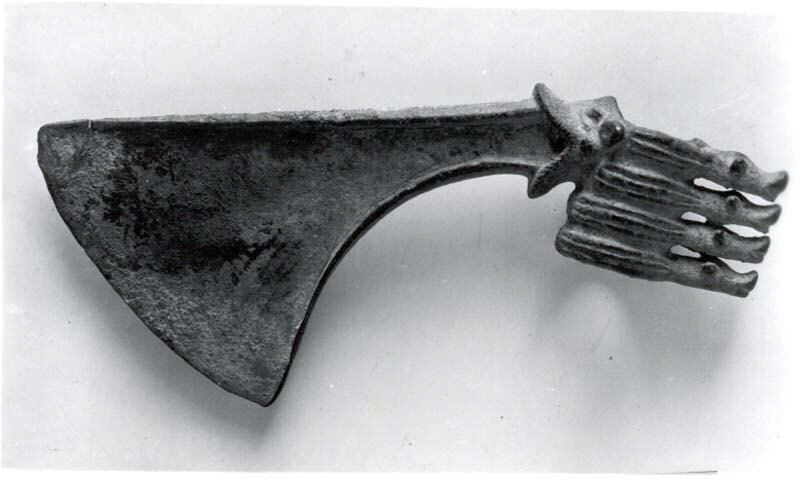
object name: axe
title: Spiked axe head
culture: iranian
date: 1200-900 BCE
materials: bronze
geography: western iran